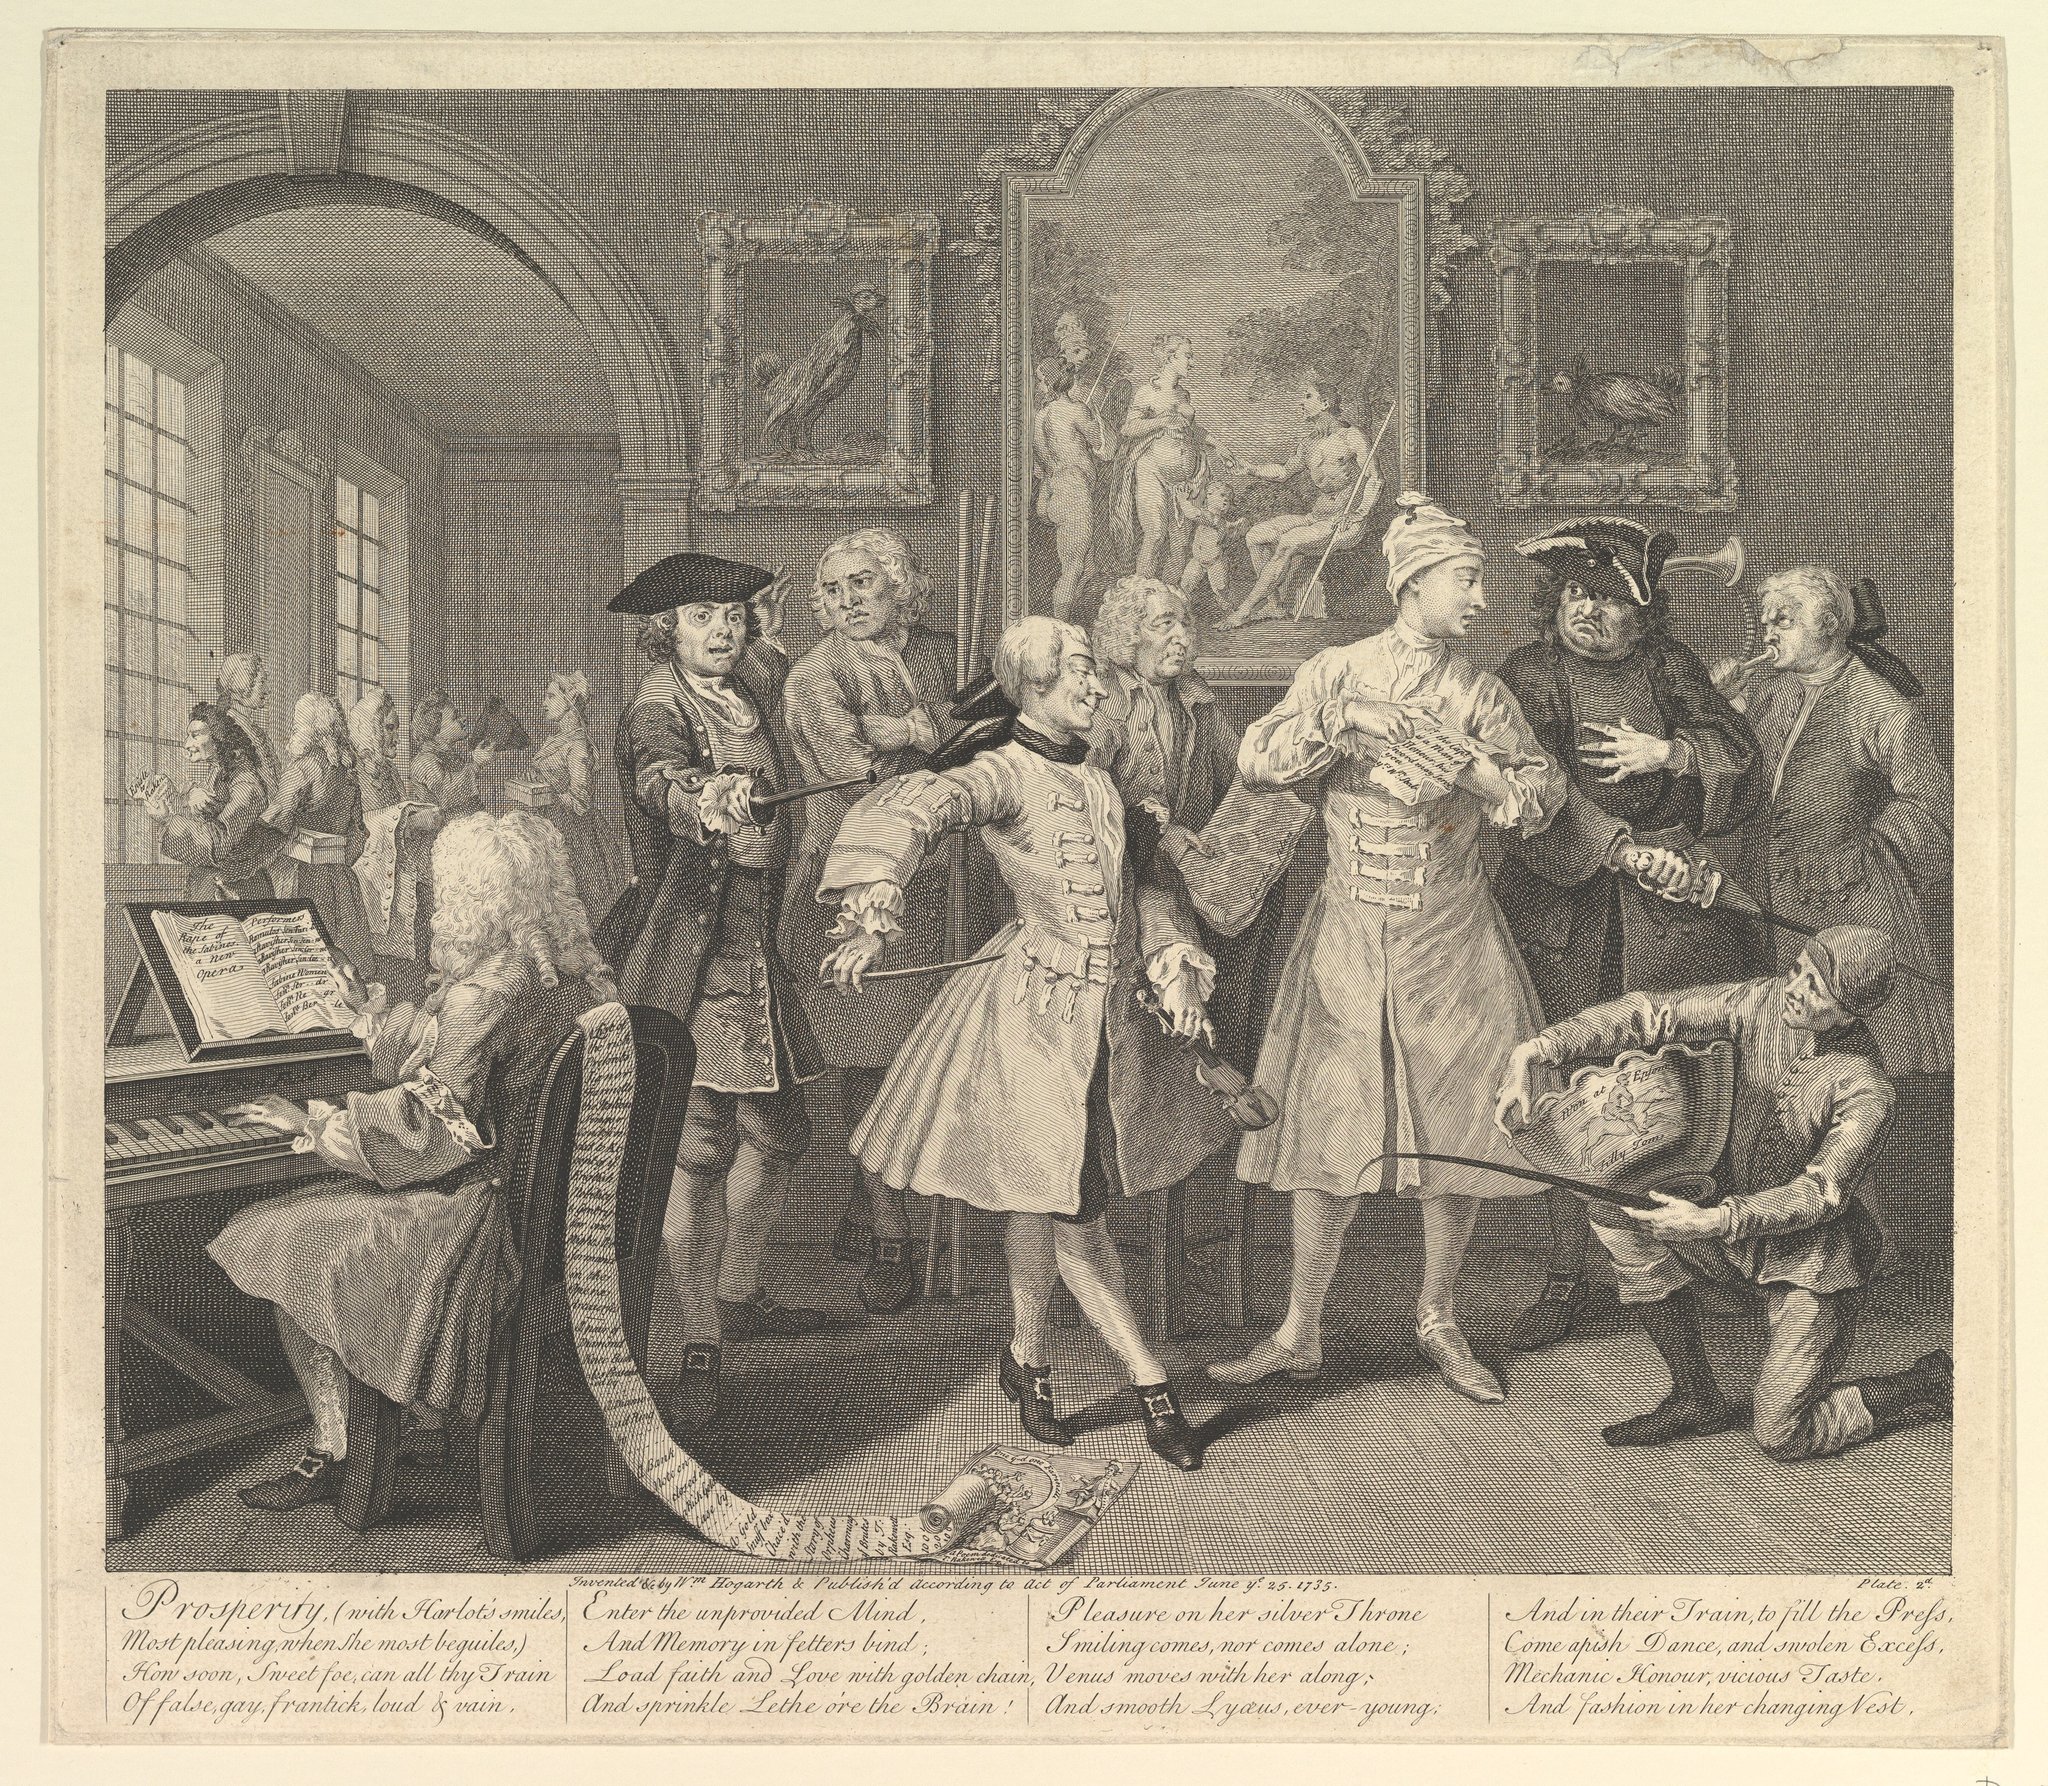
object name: print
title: A Rake's Progress, Plate 2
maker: william hogarth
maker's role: artist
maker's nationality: british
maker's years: 1697-1764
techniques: engraving, etching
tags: musical instruments,men,women,musicians